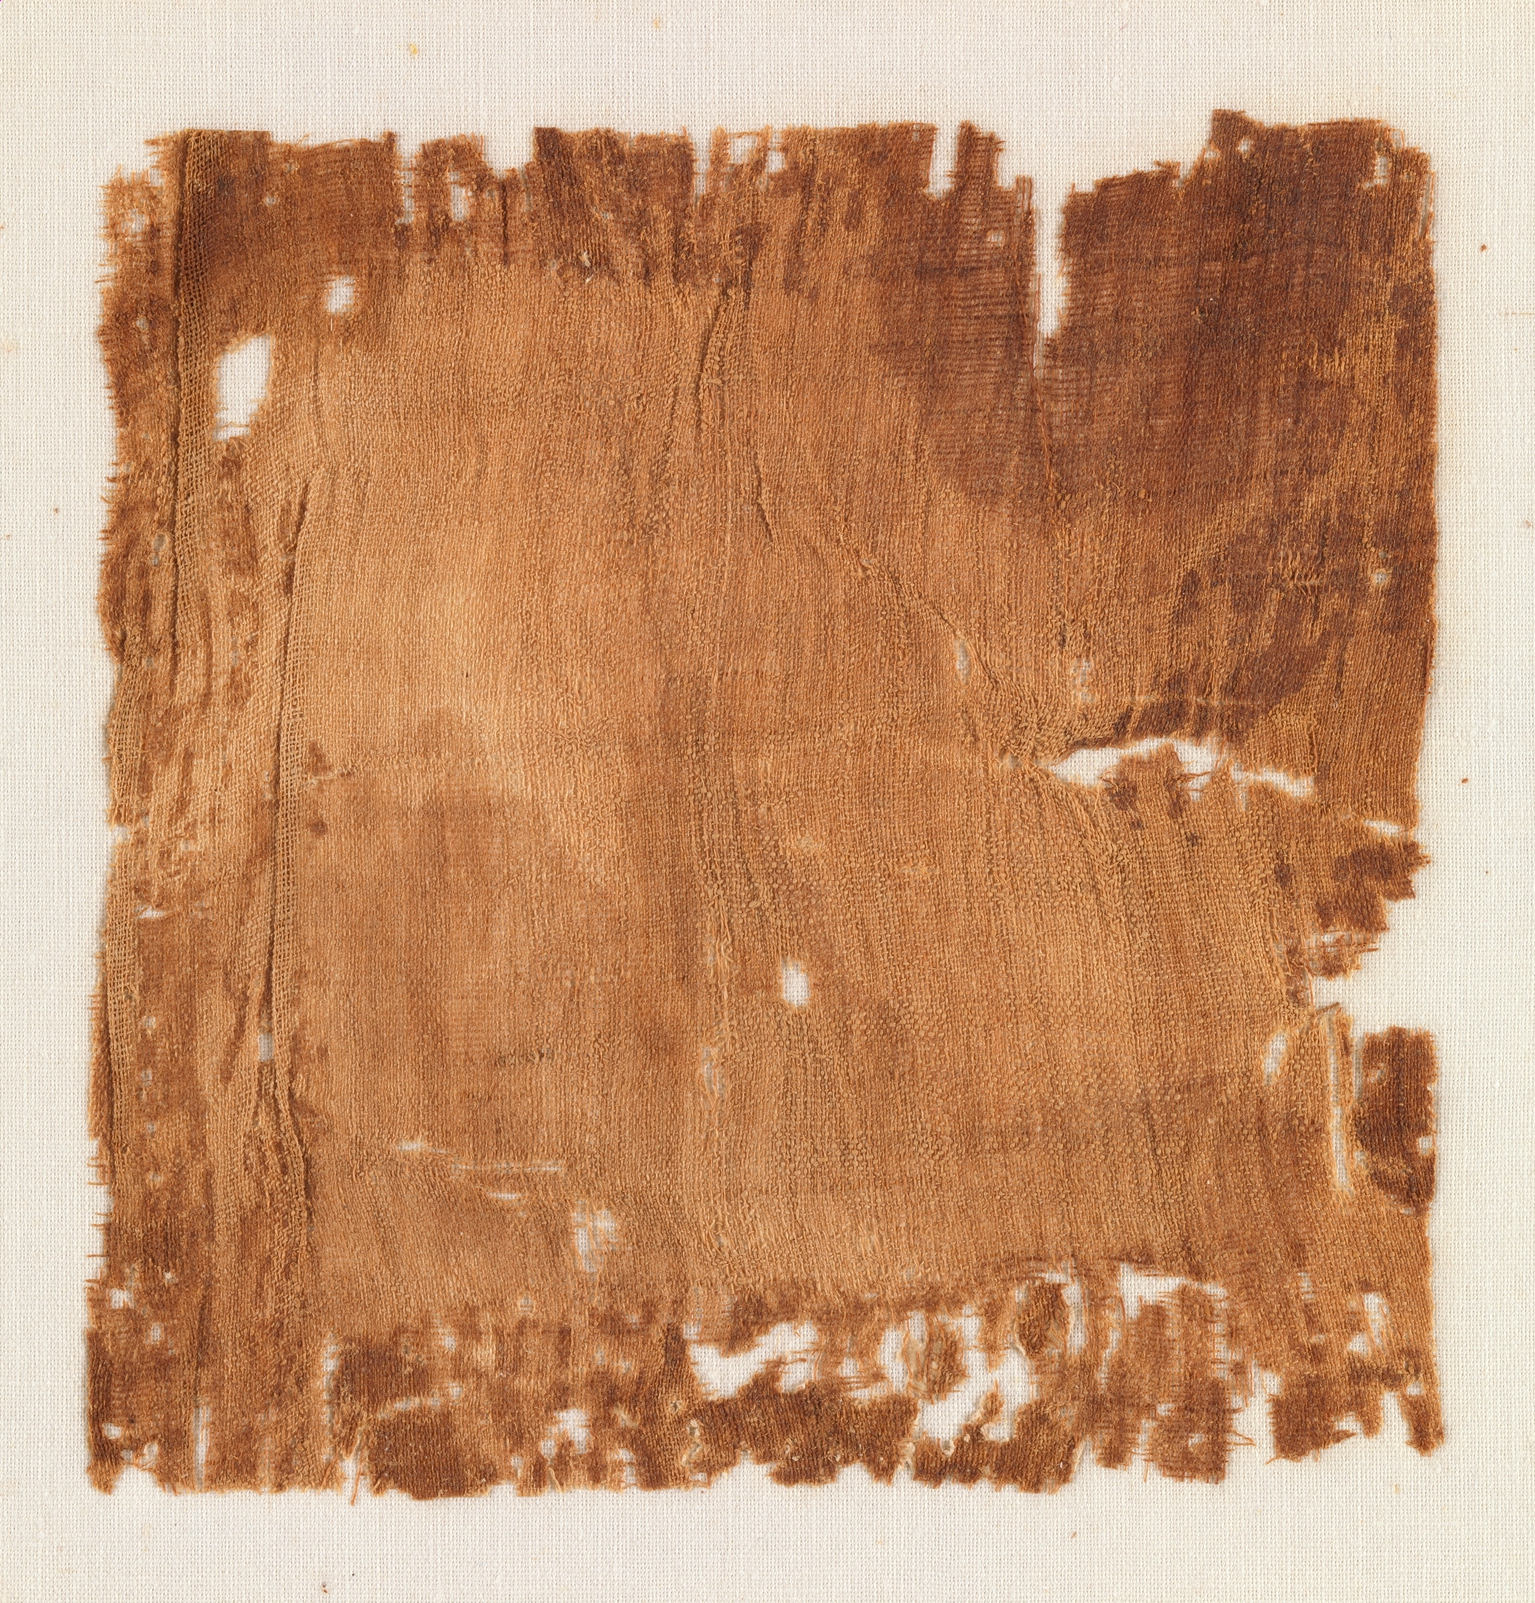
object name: mummy cloth fragment, pepi i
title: Sample of Cloth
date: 2353-2323 BCE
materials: linen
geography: egypt